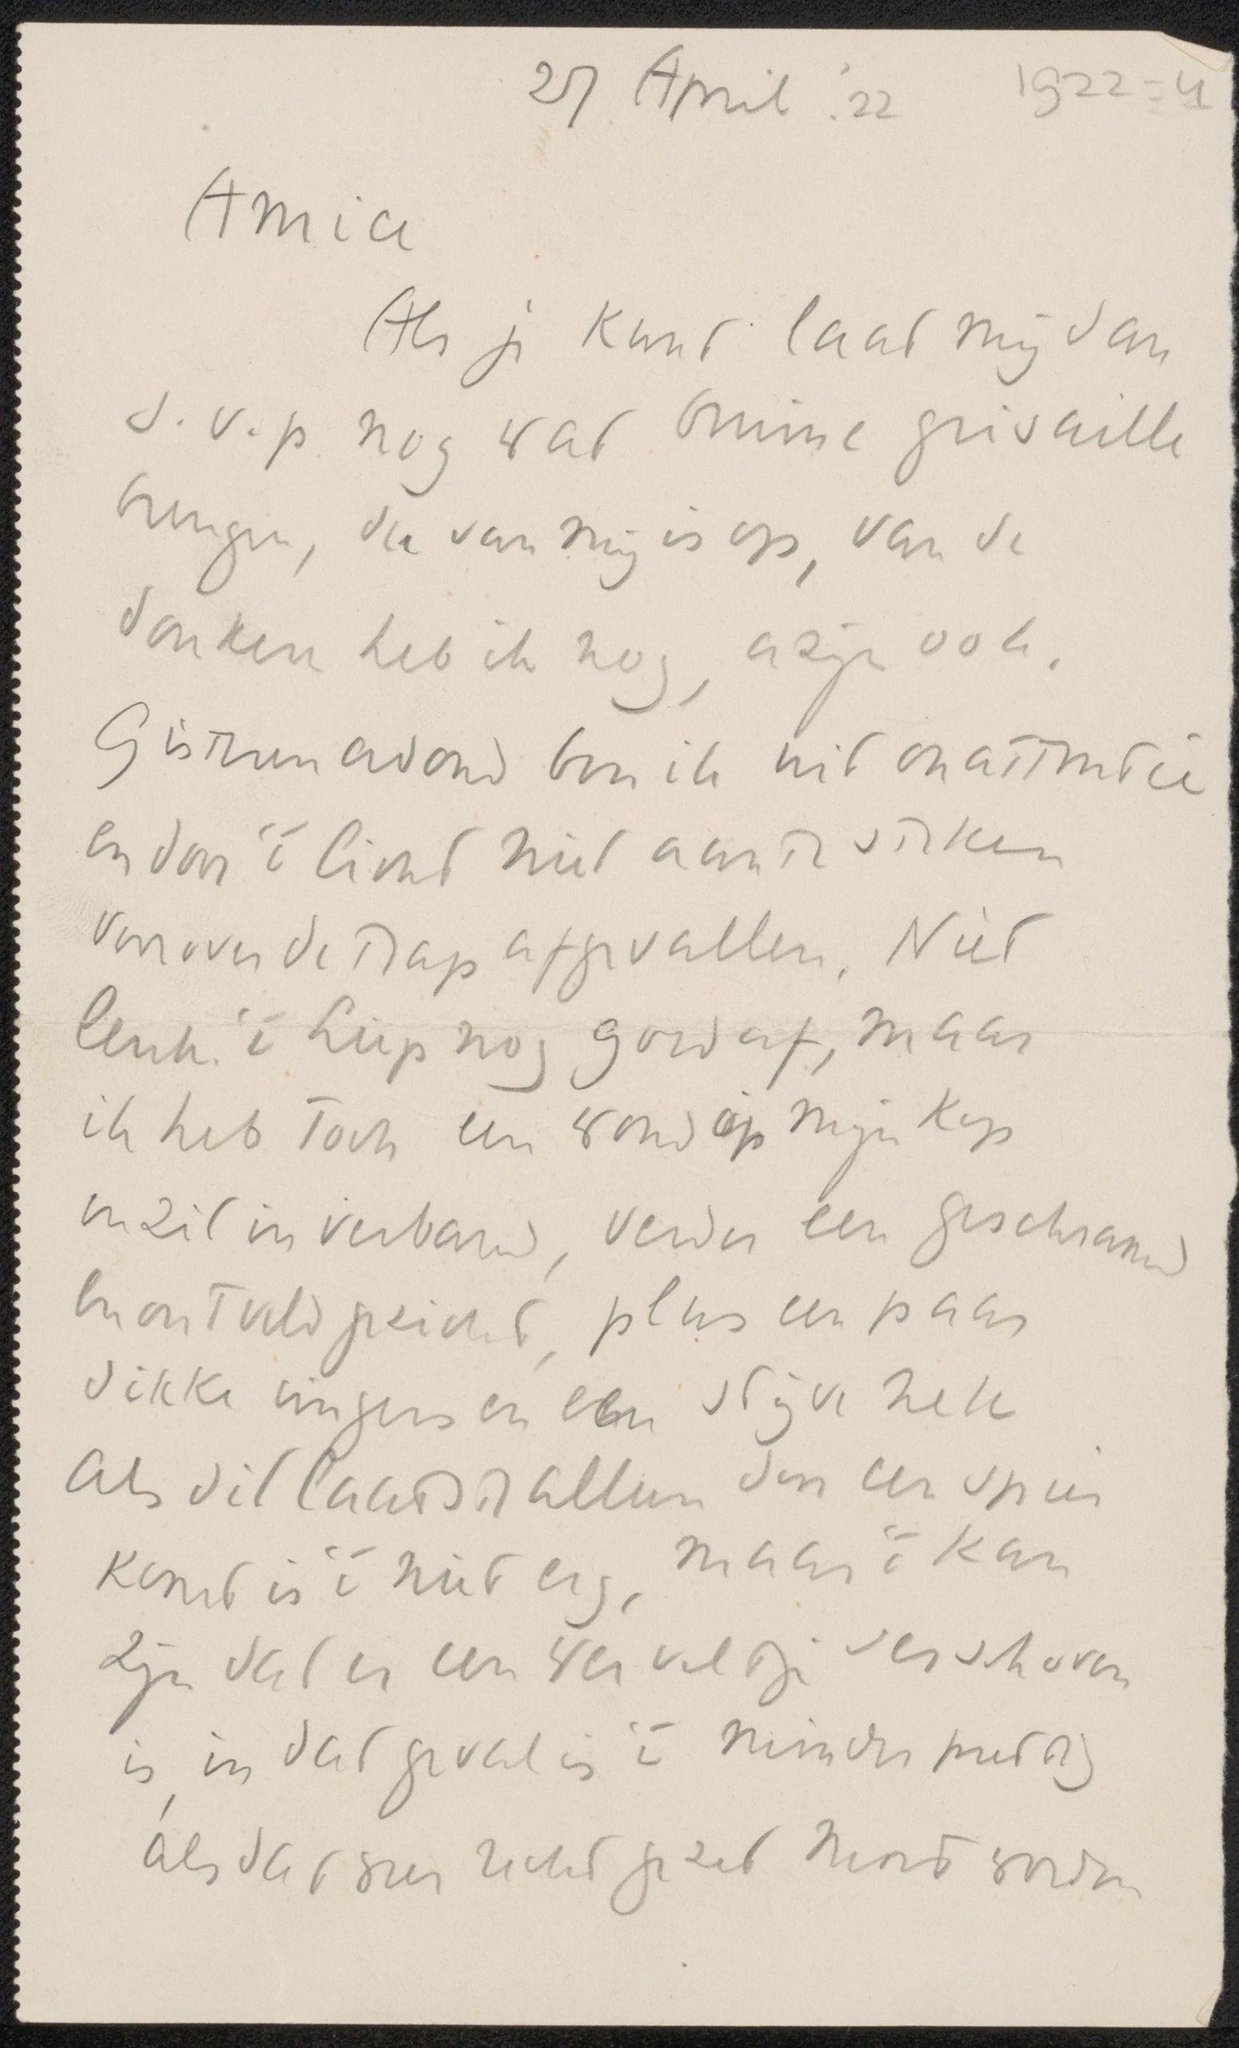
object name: letter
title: Brief aan Willem Bogtman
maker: richard nicolaüs roland holst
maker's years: 1868-1938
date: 1922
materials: ink, paper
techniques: pen, writing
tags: haarlem, willem bogtman, drawing, diseases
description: Brief gedateerd 27 April door schrijver, met toevoeging 22 in latere hand.